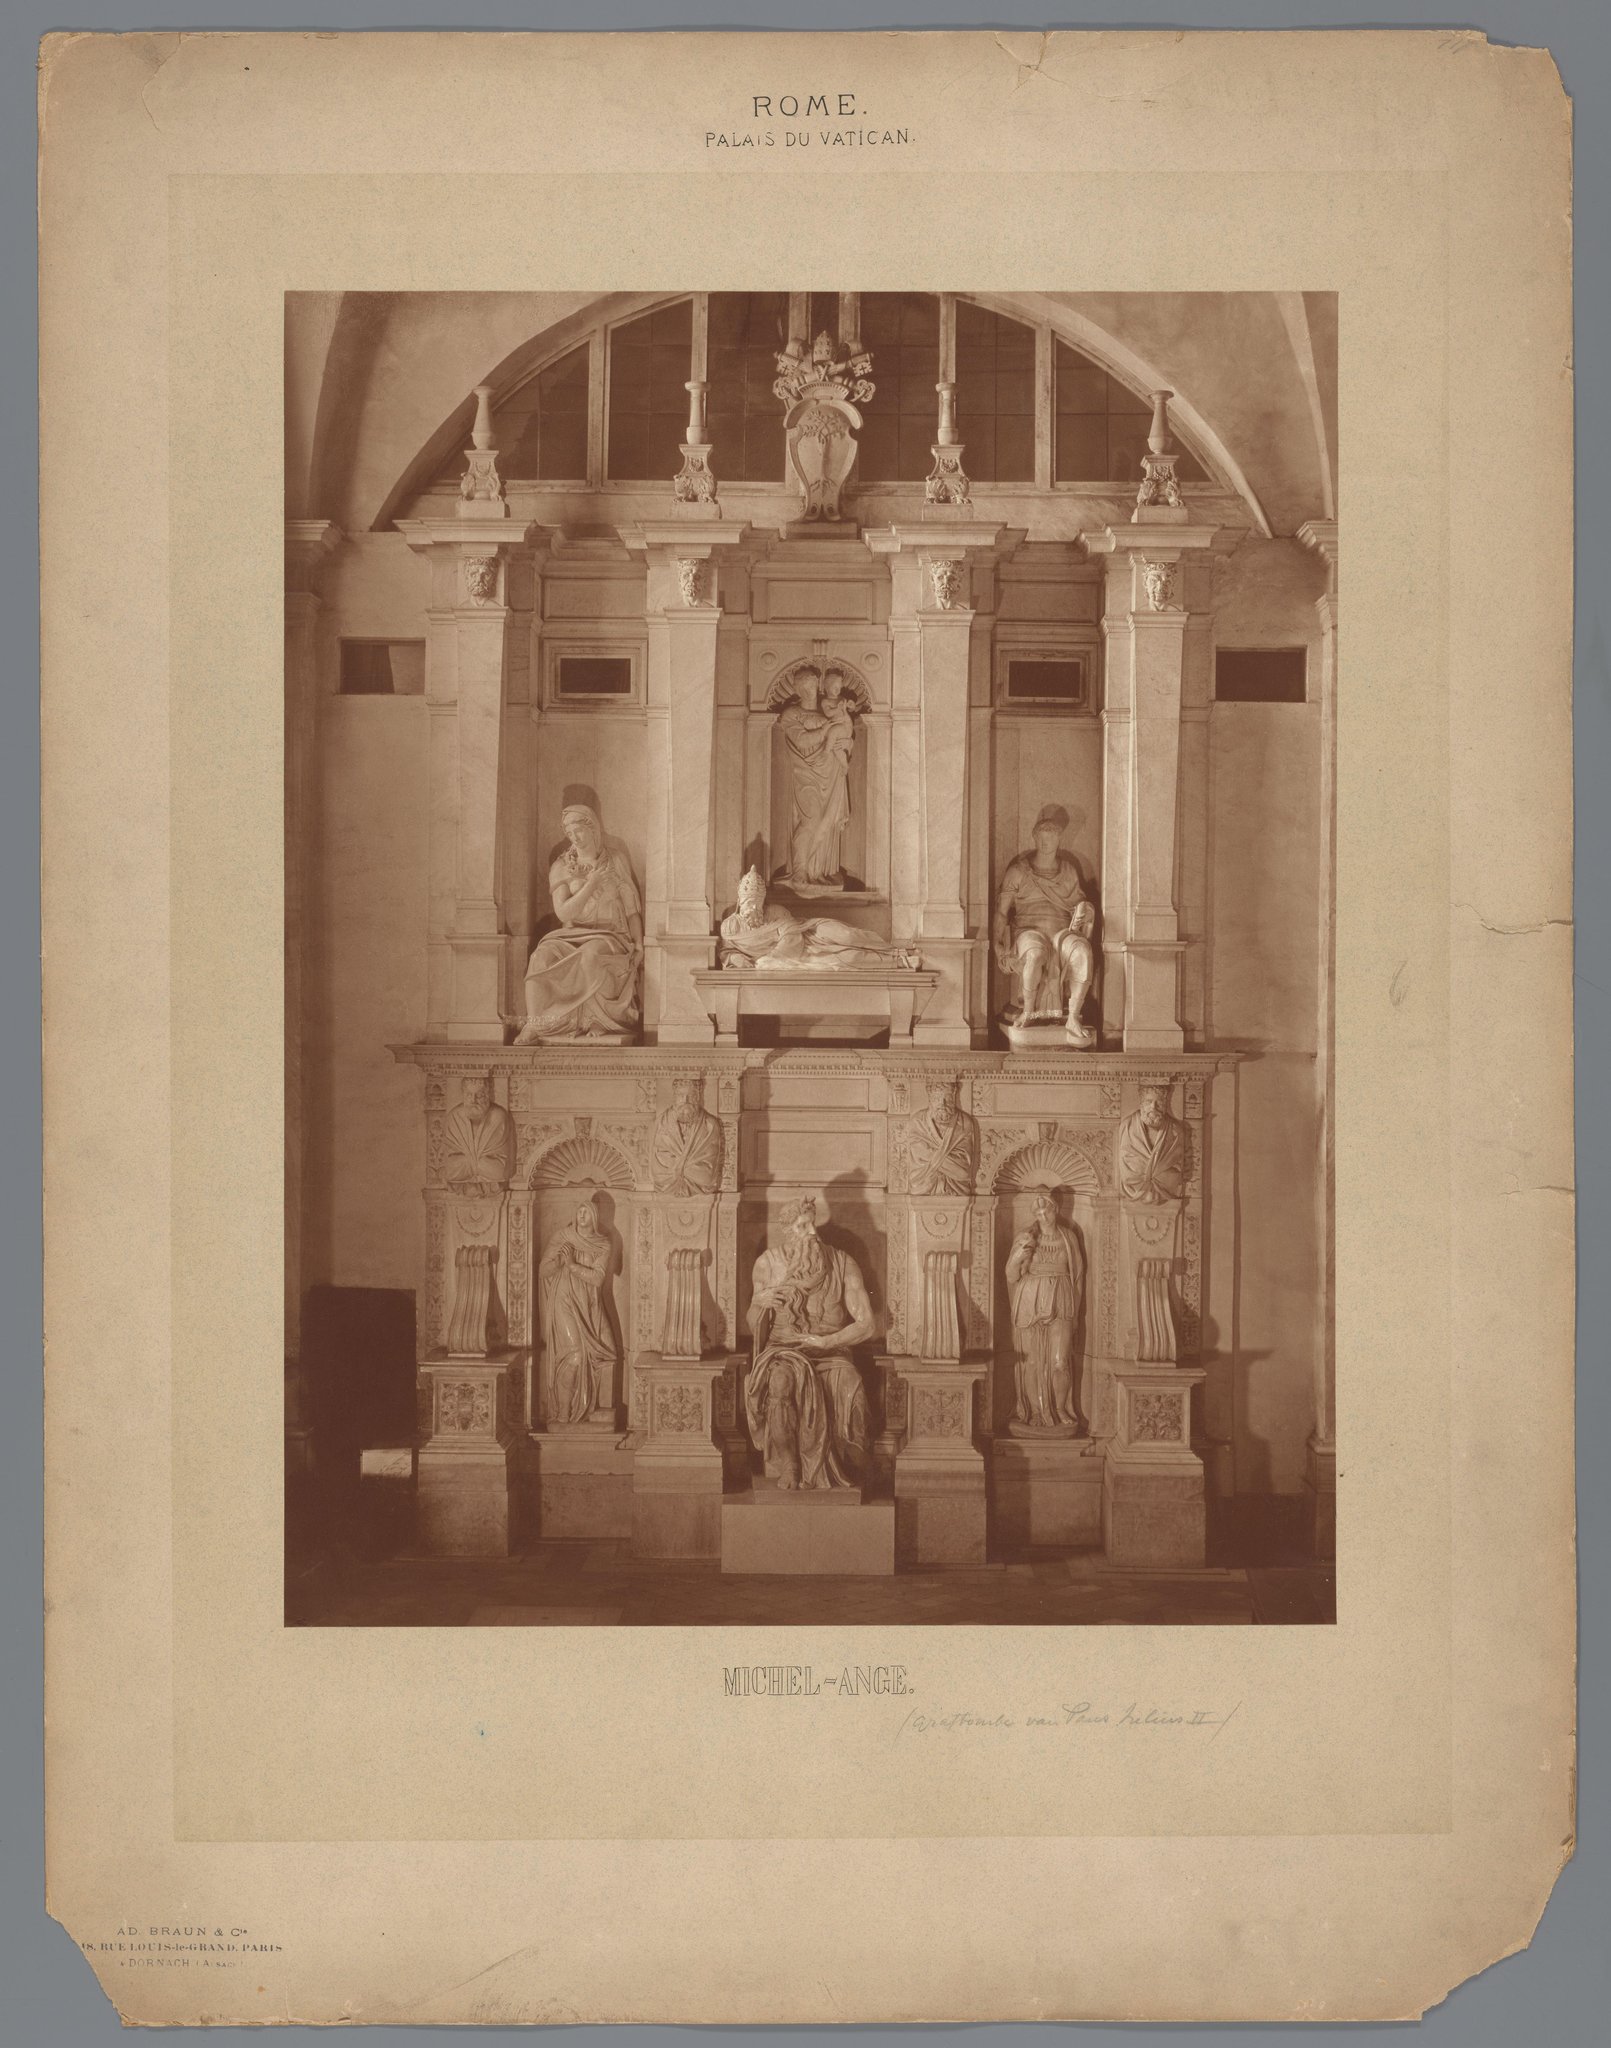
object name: photograph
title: Michelangelo's grafmonument voor paus Julius II in de Sint-Pieter, Vaticaan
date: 1880-1900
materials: cardboard, paper, photographic support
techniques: carbon print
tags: painter, draughtsman, michelangelo, rome